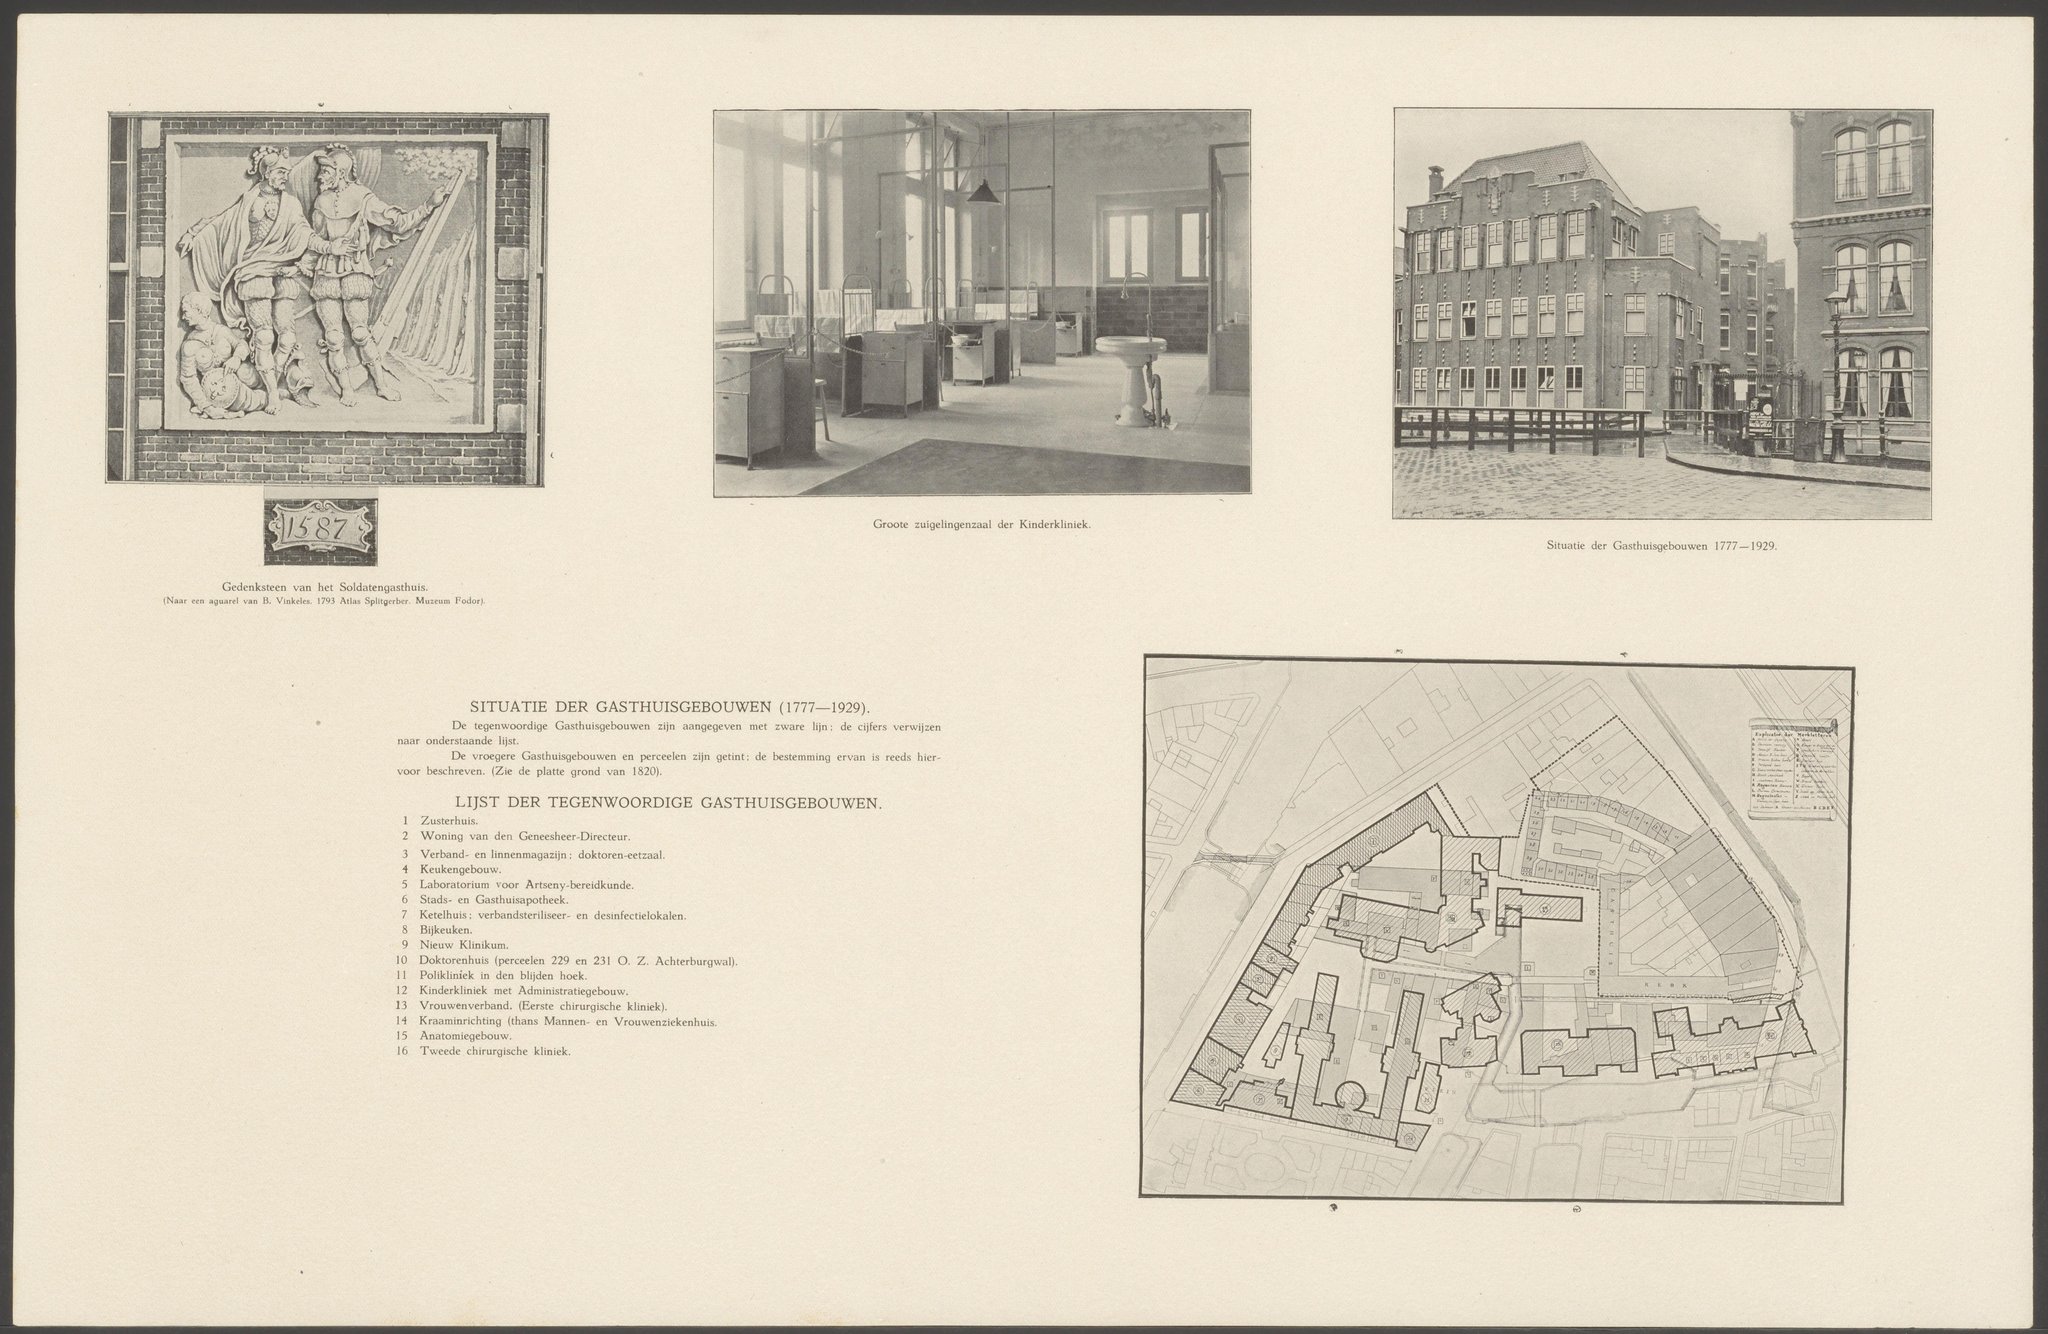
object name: photomechanical print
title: Voorstellingen rond het Binnengasthuis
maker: Anonymous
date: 1912-1970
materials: paper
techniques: letterpress printing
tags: hospital, maps of cities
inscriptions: collector's mark: Lugt 1641b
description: Vier losse voorstellingen over het Binnengasthuis, met een gedenksteen van het Soldatengasthuis, de zuigelingenzaal, de gasthuisgebouwen en een plattegrond van de gasthuisgebouwen. Onderwerpsrubriek binnen de Atlas Amsterdam: Armwezen en liefdadige instellingen: I. Stadsinrichtingen: Binnengasthuis.